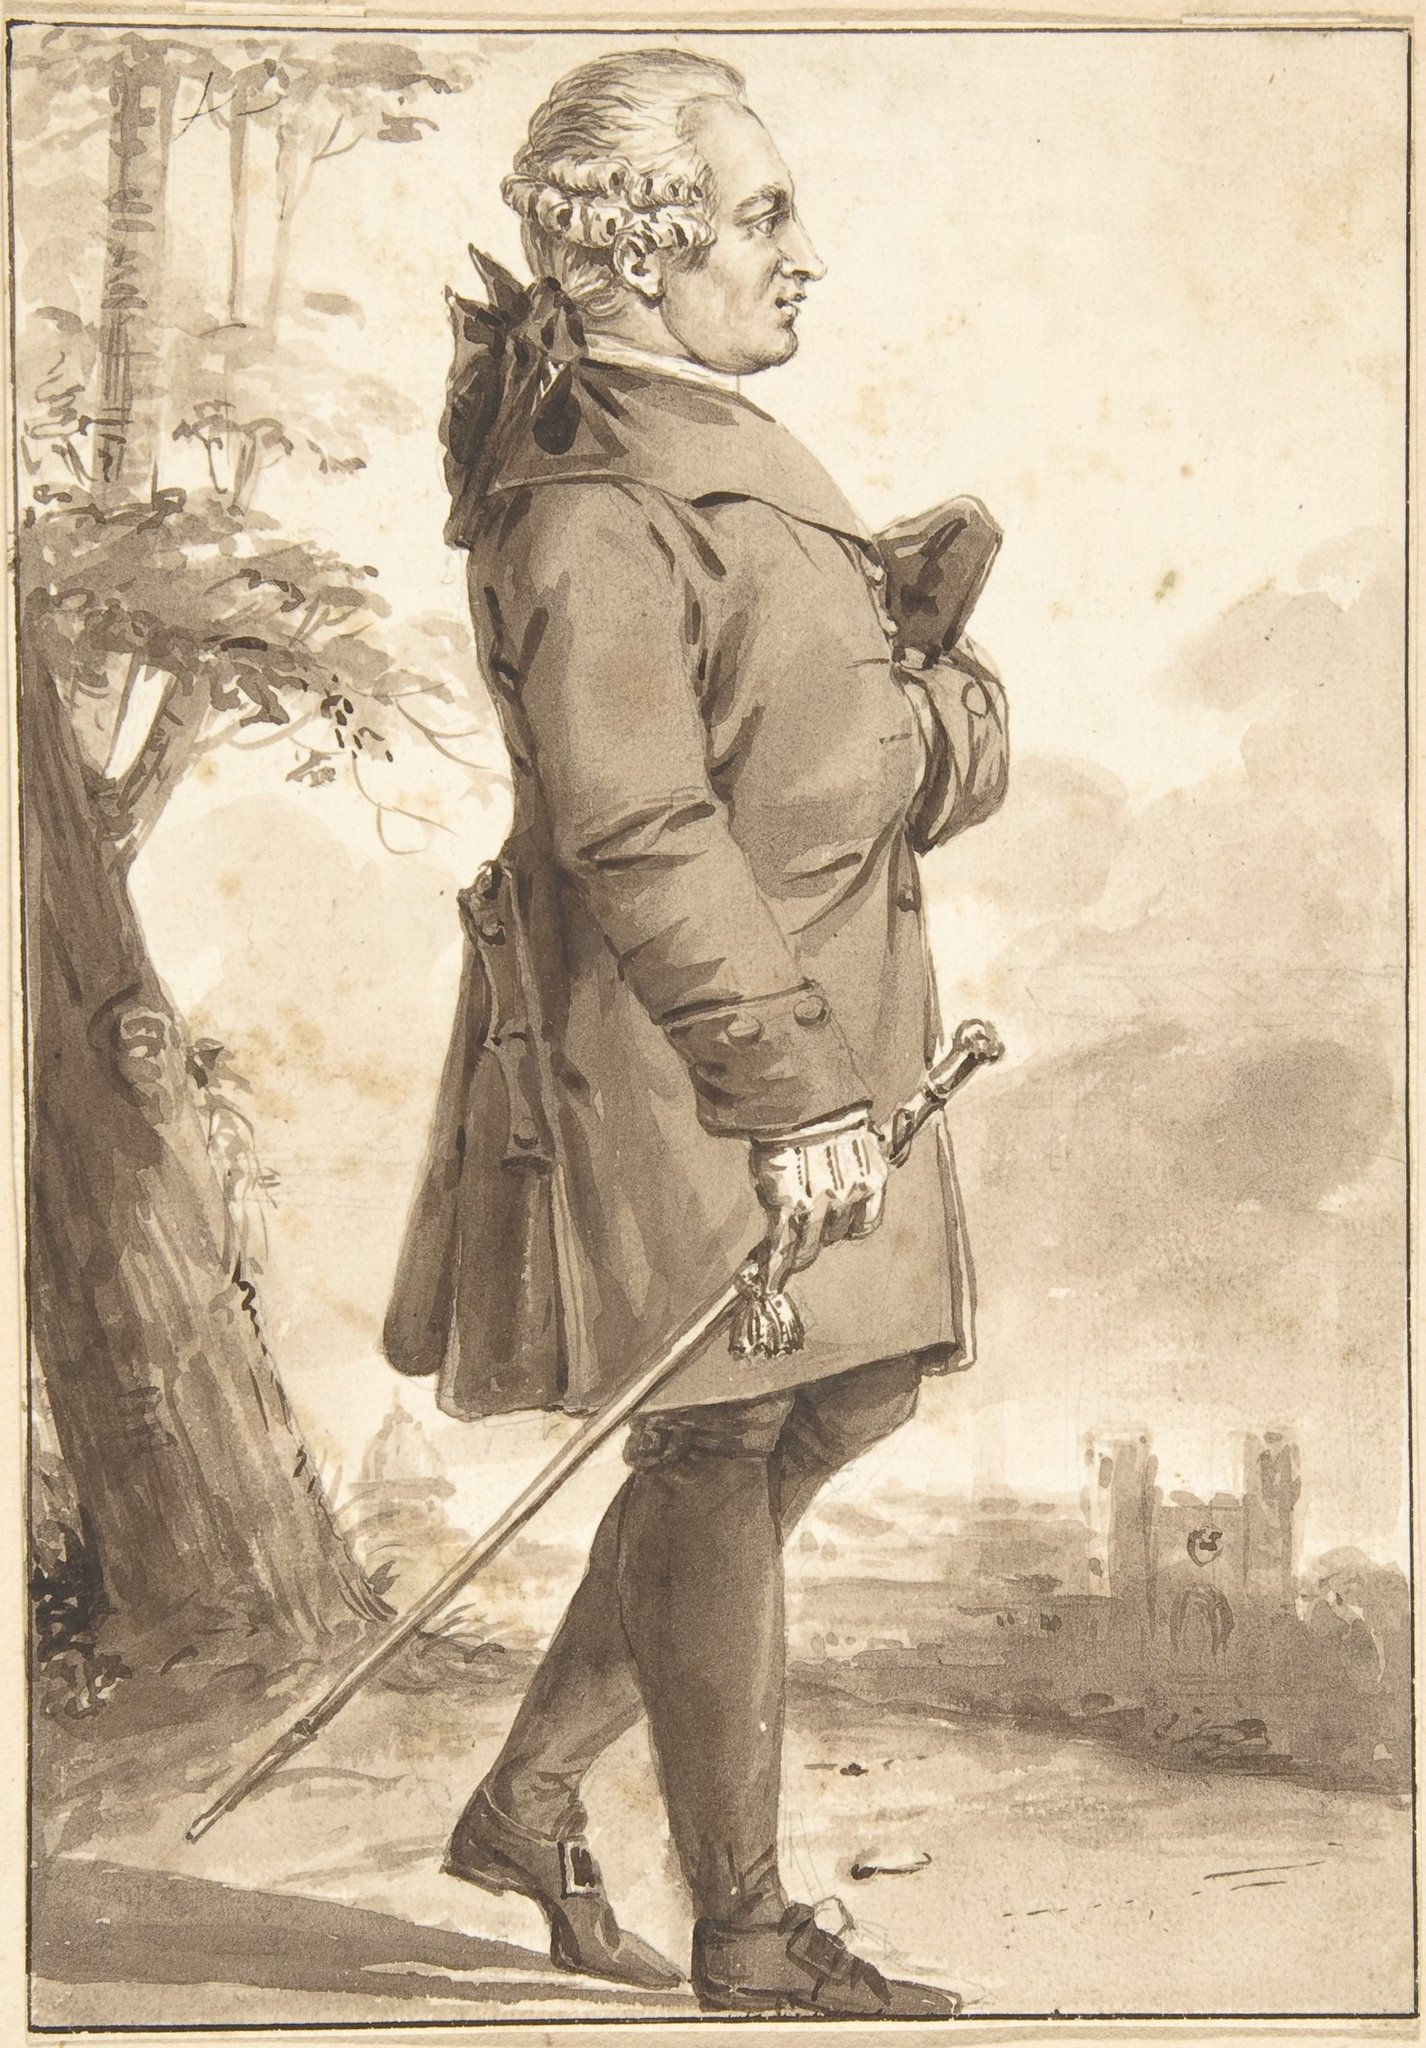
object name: drawing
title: Portrait of P.-A. Caron de Beaumarchais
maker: jean-baptiste-françois bosio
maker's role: artist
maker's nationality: french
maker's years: 1764-1827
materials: graphite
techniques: brush, wash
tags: men,portraits